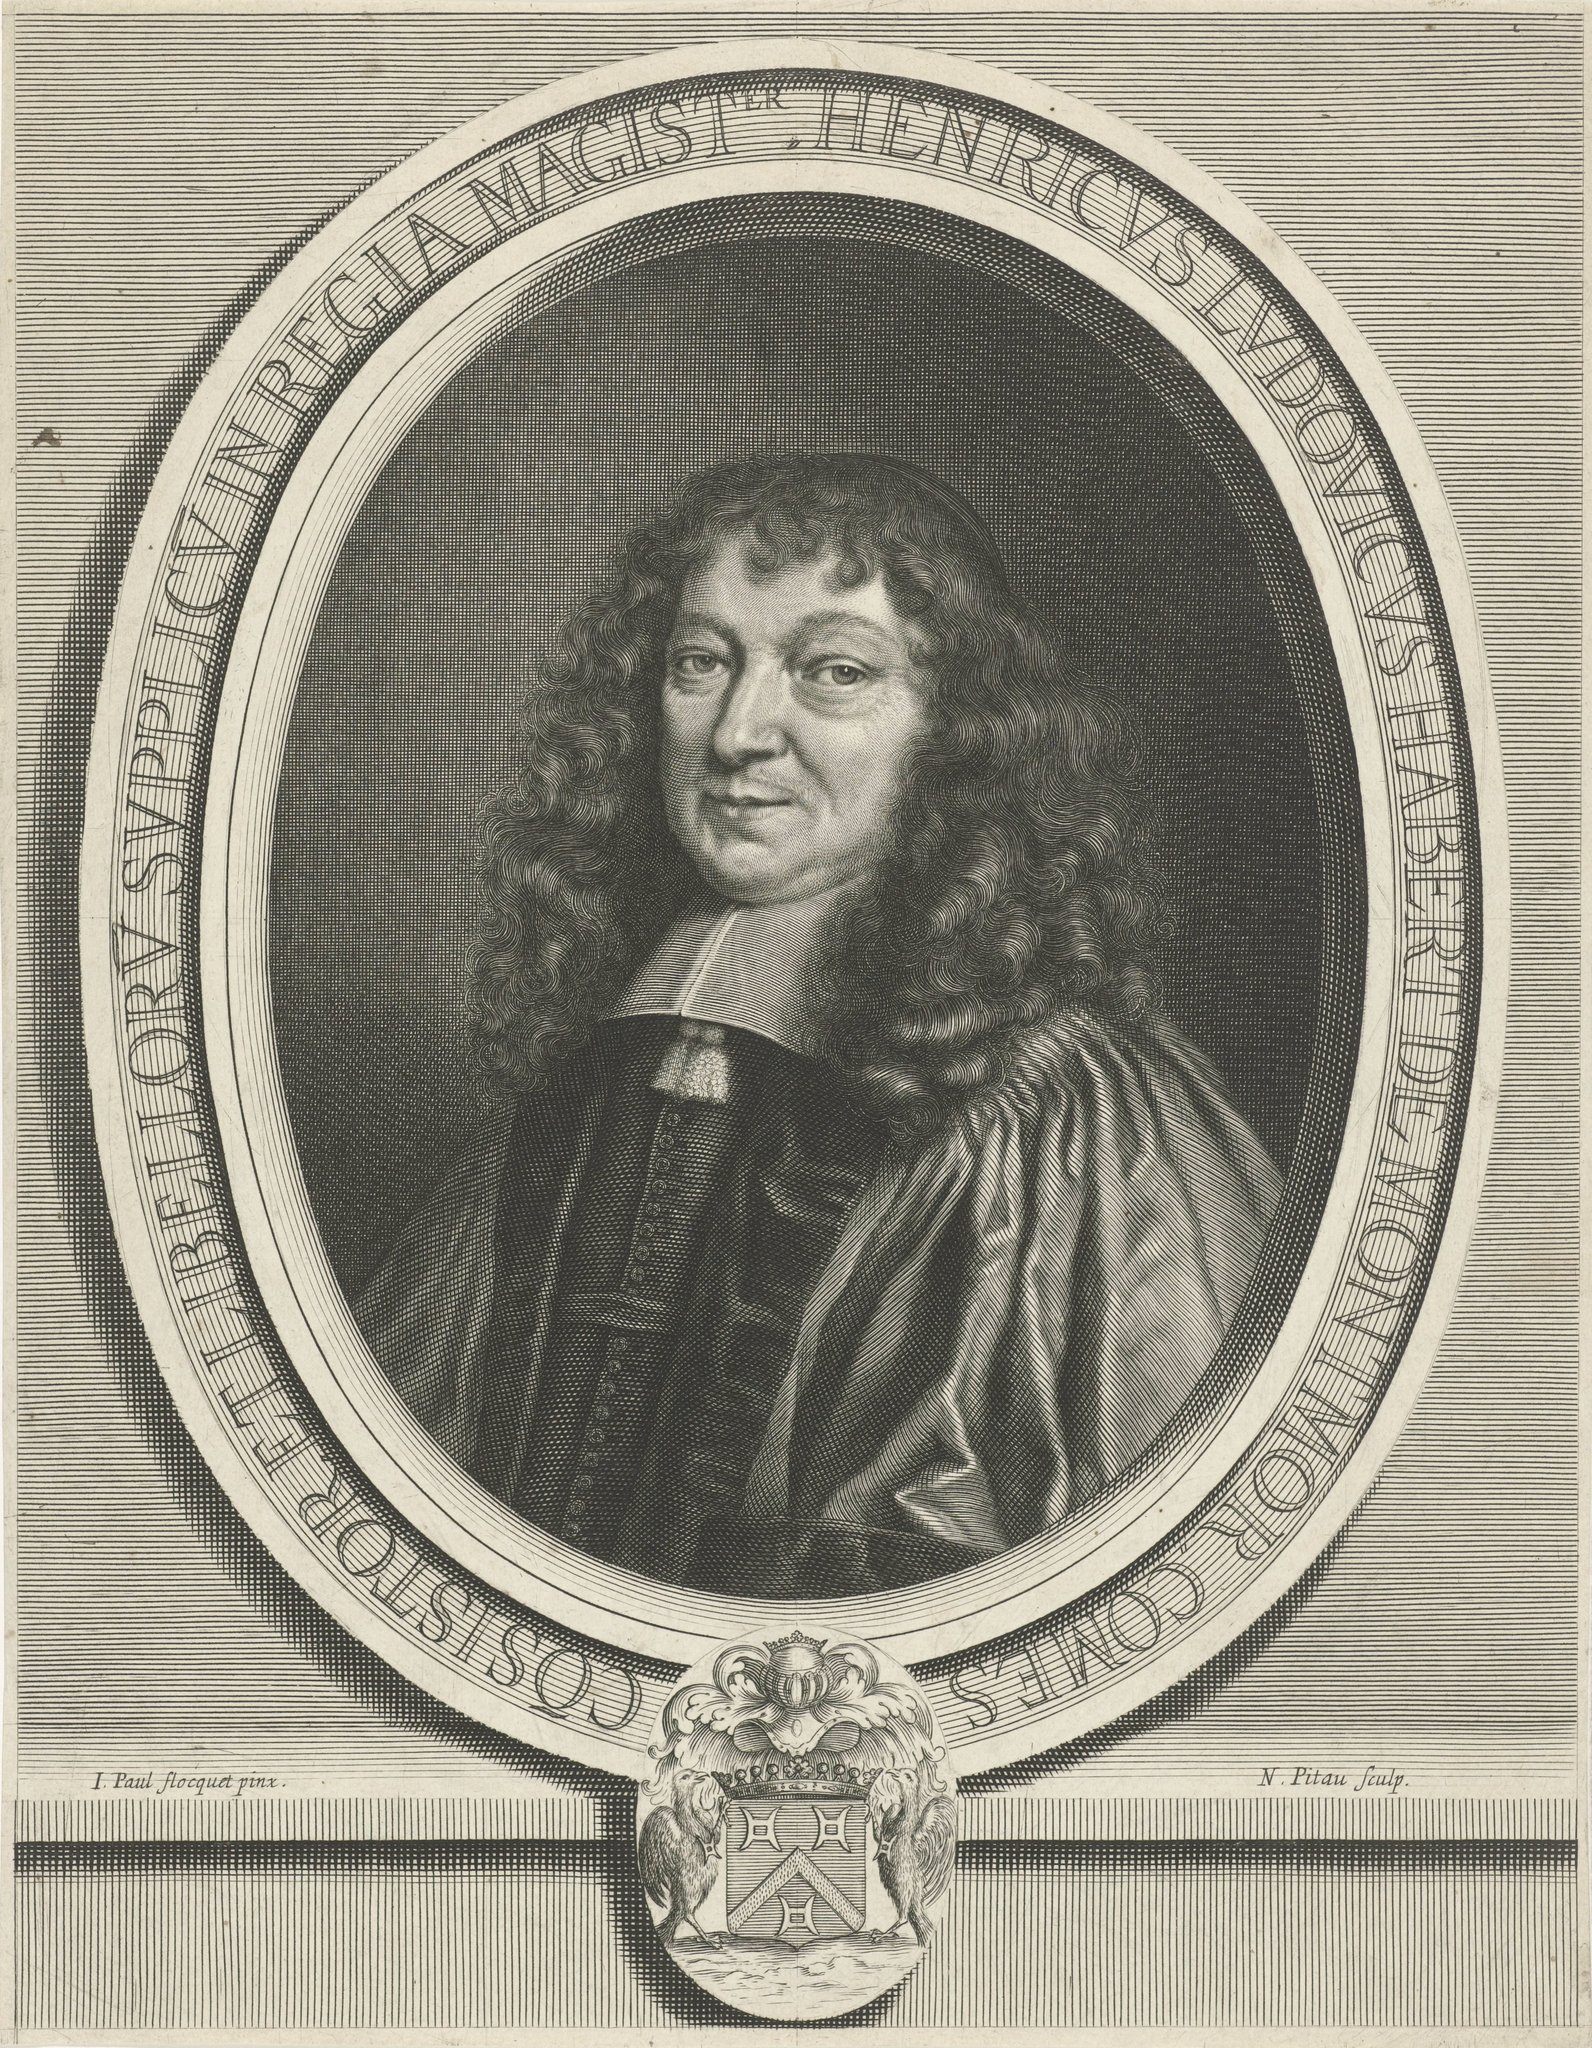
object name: print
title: Portret van Henri Louis Habert de Montmor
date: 1644-1671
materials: paper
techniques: engraving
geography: paris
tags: paris, henri louis habert de montmor, armorial bearing, heraldry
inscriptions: collector's mark: Lugt 2228